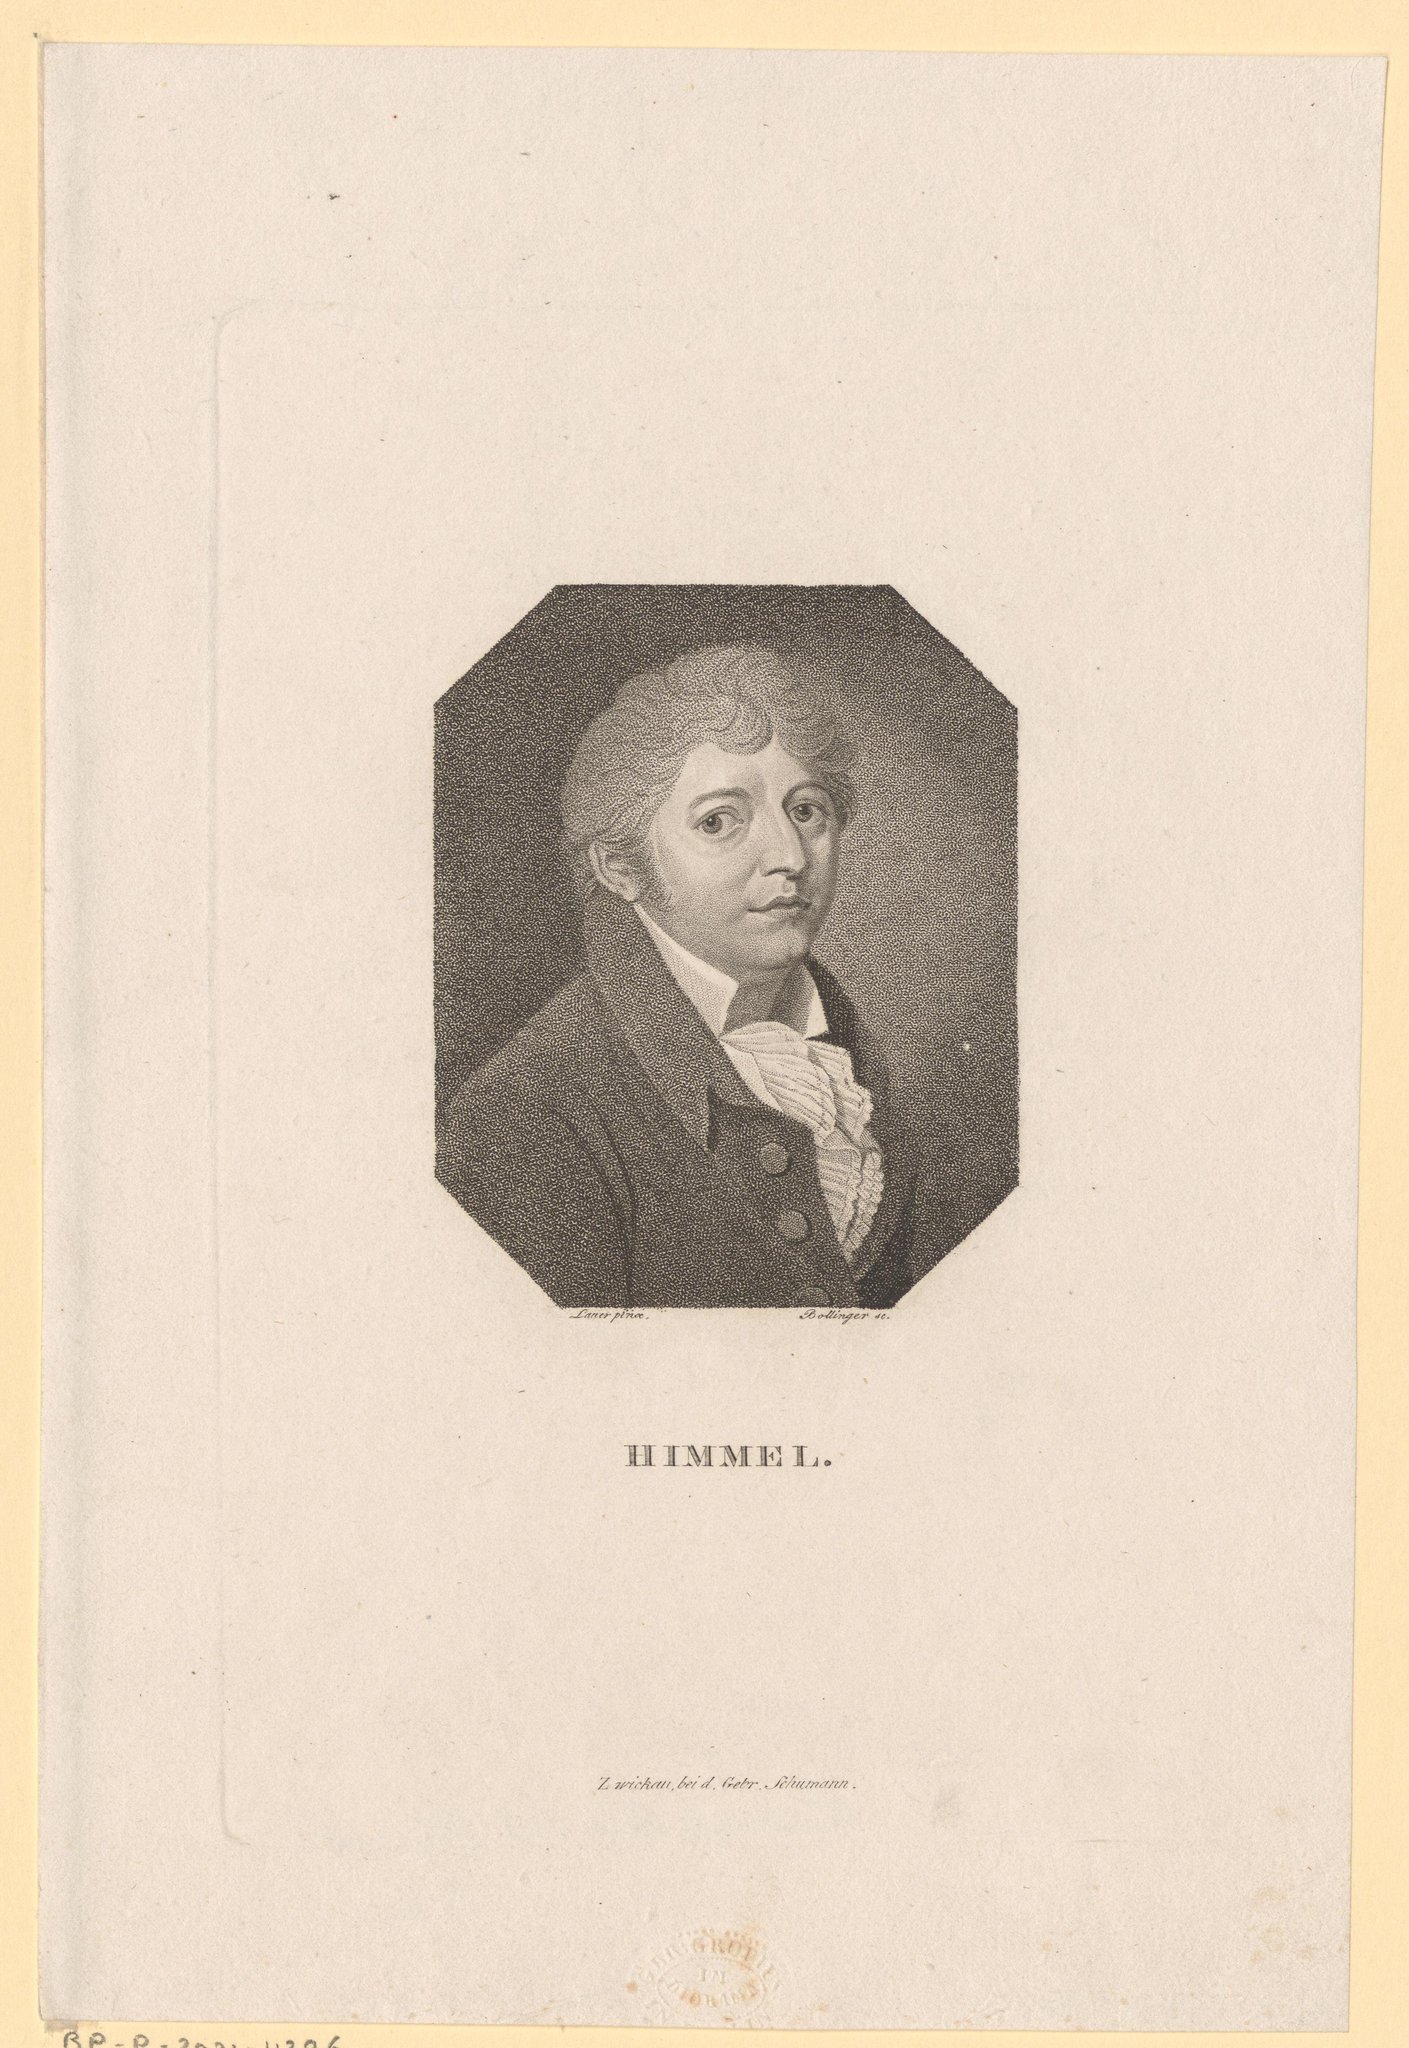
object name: print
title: Bildnisse der berühmtesten Menschen aller Völker und Zeiten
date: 1818-1832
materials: paper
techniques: stippling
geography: zwickau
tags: berlin, historical persons, portrait of composer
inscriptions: workshop stamp: Lugt 5415